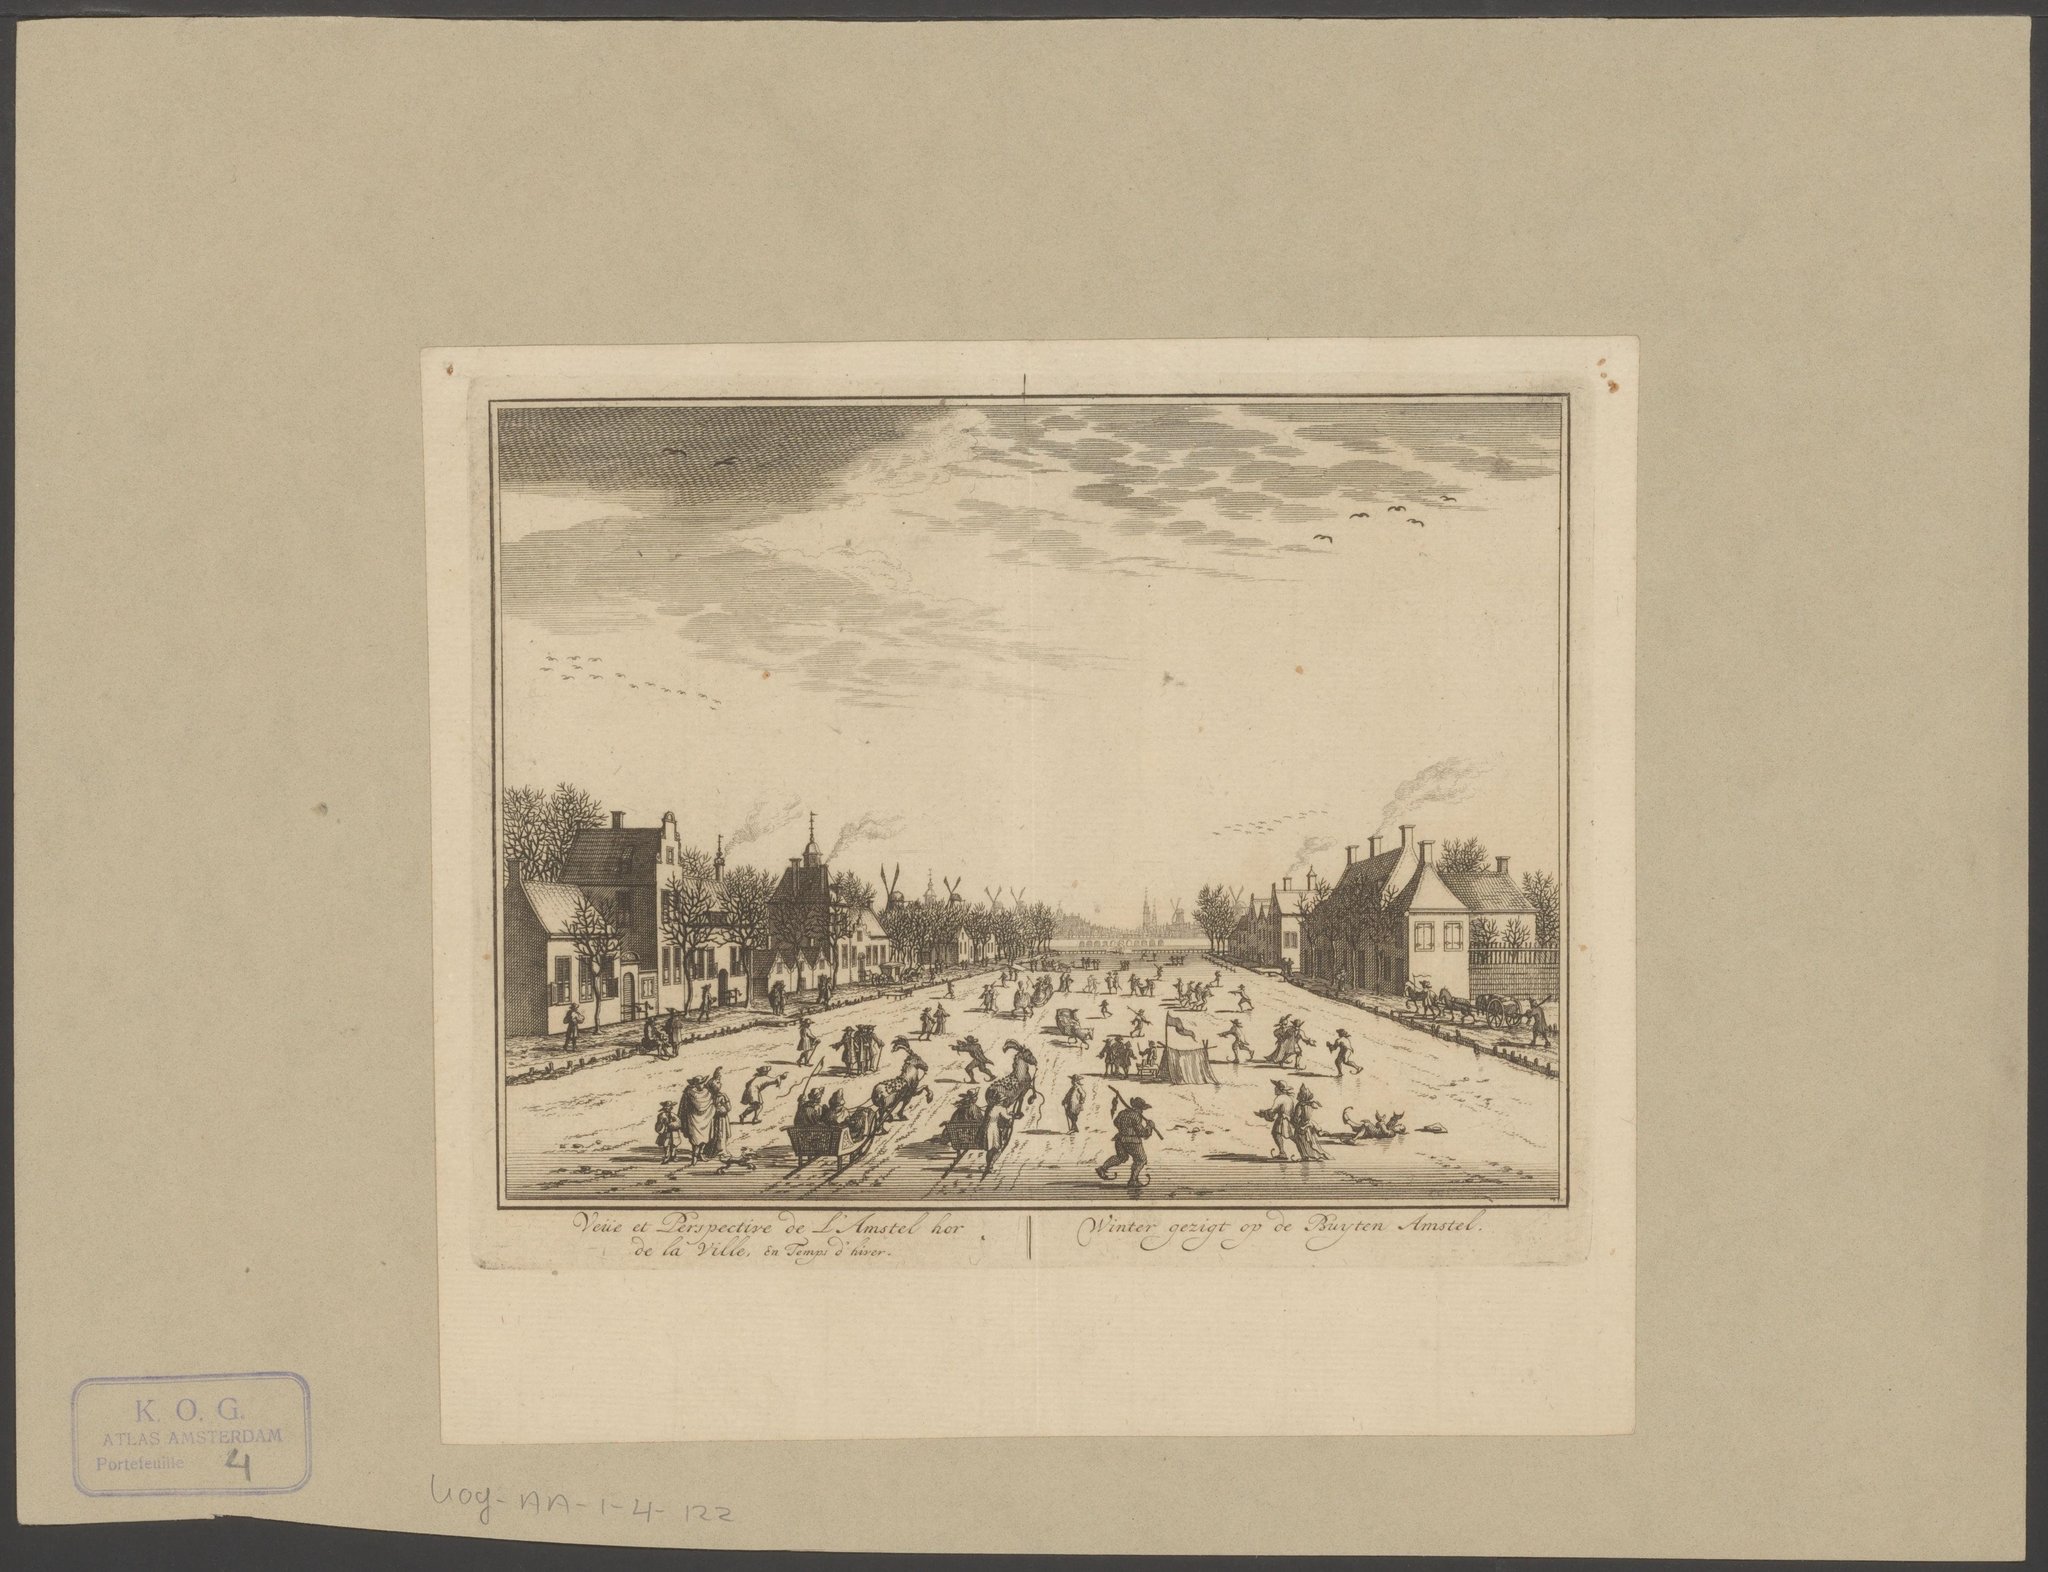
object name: print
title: Vue et Perspective de l'Amstel hor de la Ville , en Temps d' hiver / Winter Gezigt op de Buyten Amstel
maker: Anonymous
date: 1750-1770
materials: paper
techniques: etching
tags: city-view in general; 'veduta', river, winter landscape; landscape symbolizing winter (the four seasons of the year), skates (winter sports)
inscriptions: collector's mark: ‘4’ Lugt 1641b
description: Onderwerpsrubriek binnen de Atlas Amsterdam: Amstel van Hogesluis stroomopwaarts. Rechtsonder genummerd: 1.